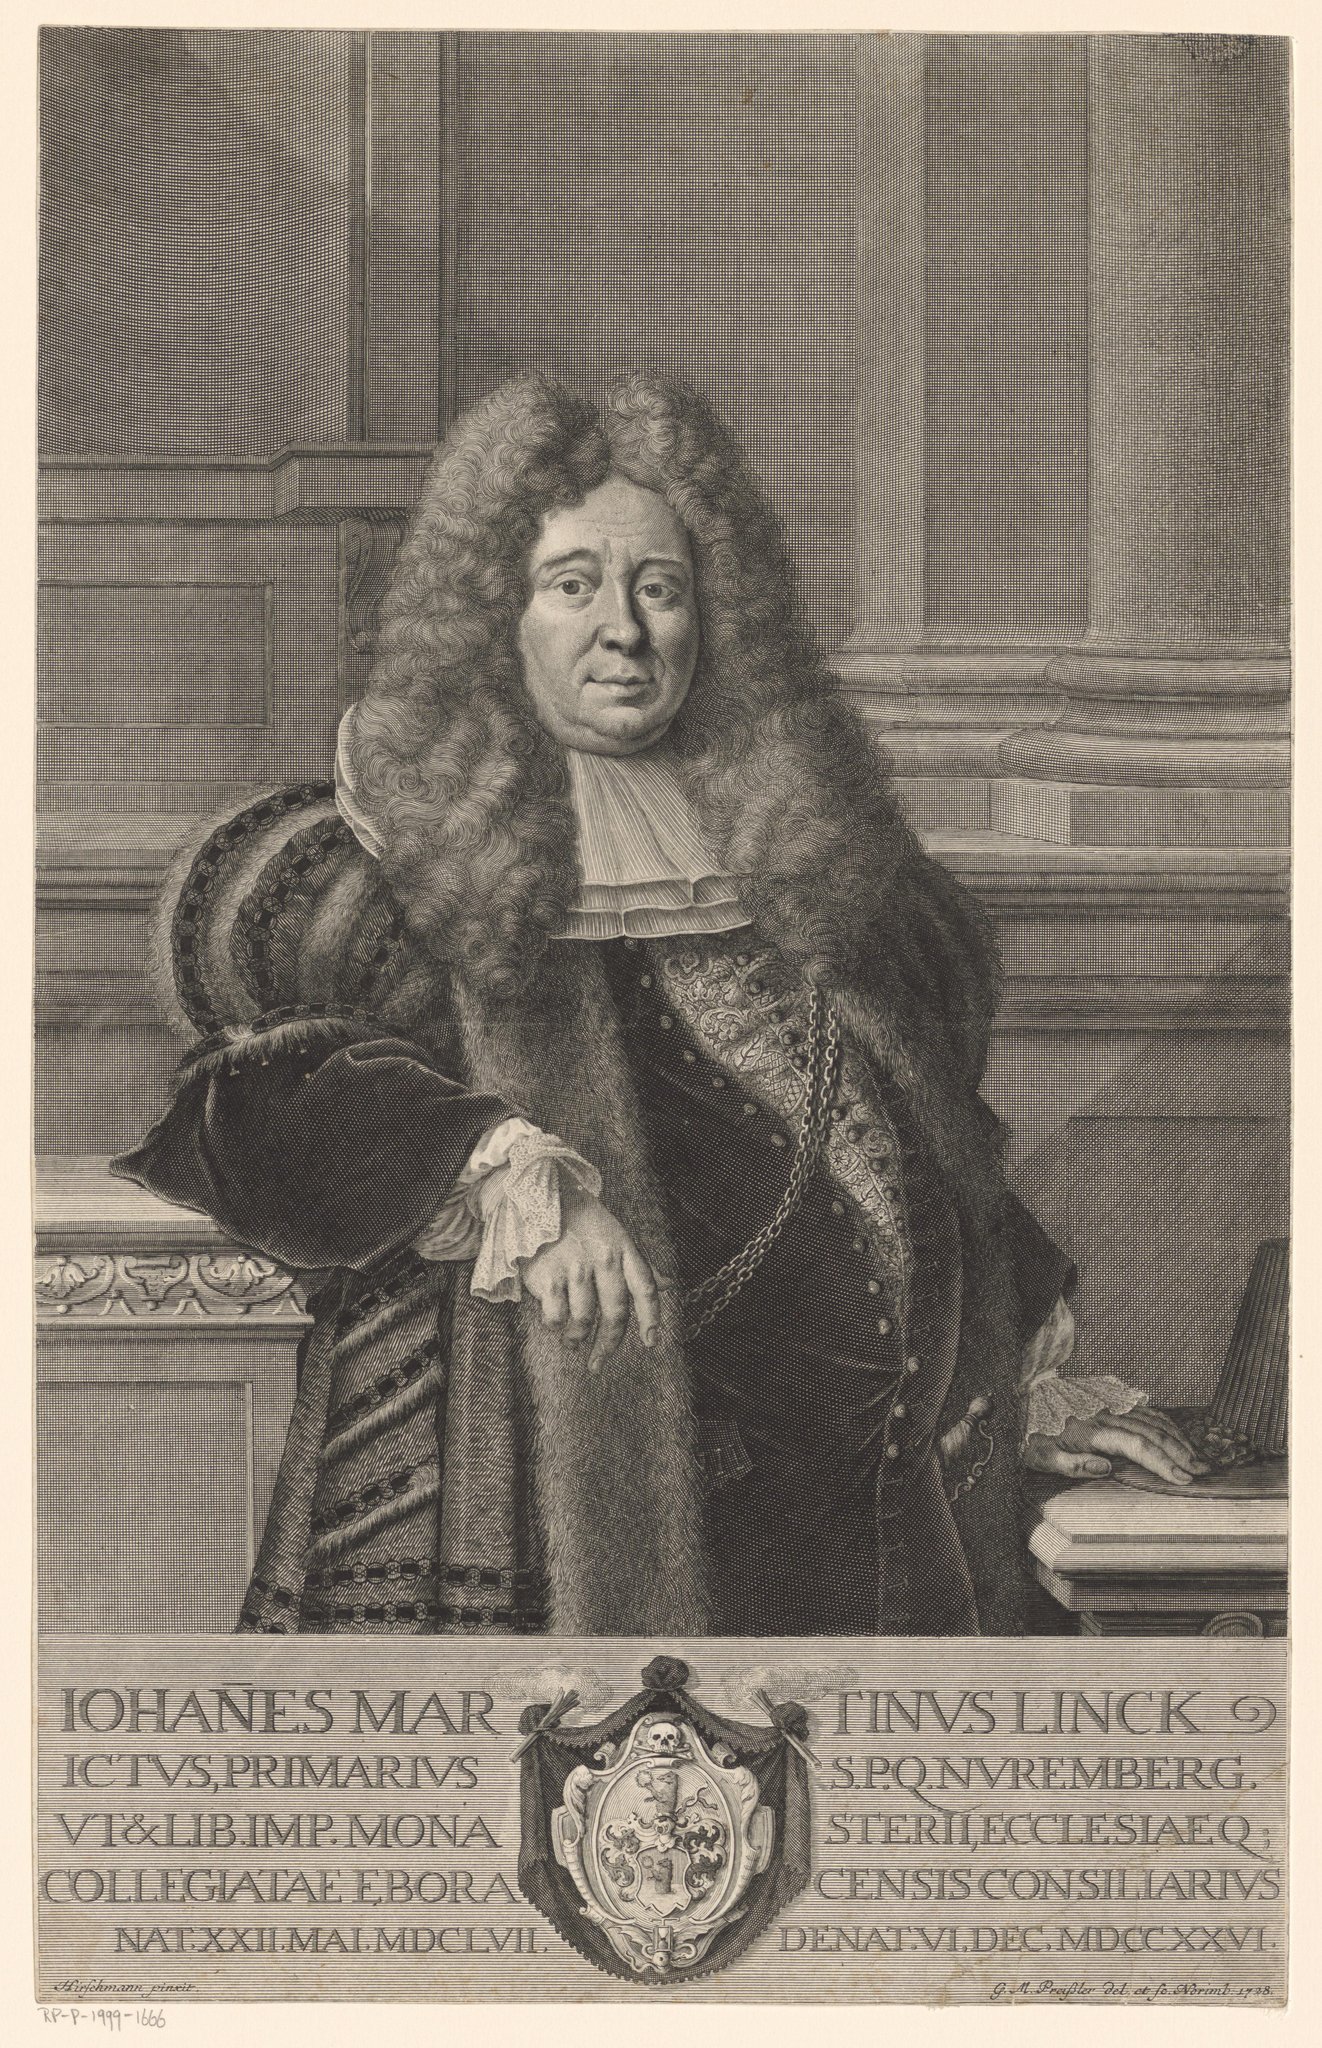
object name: print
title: Portret van Johann Martin Linck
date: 1728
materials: paper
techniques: engraving, etching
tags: historical persons, armorial bearing, heraldry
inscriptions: inscription: ‘No 2412’, collector's mark: Lugt 2228, collector's mark: Lugt 4100, collector's mark: Lugt 2760